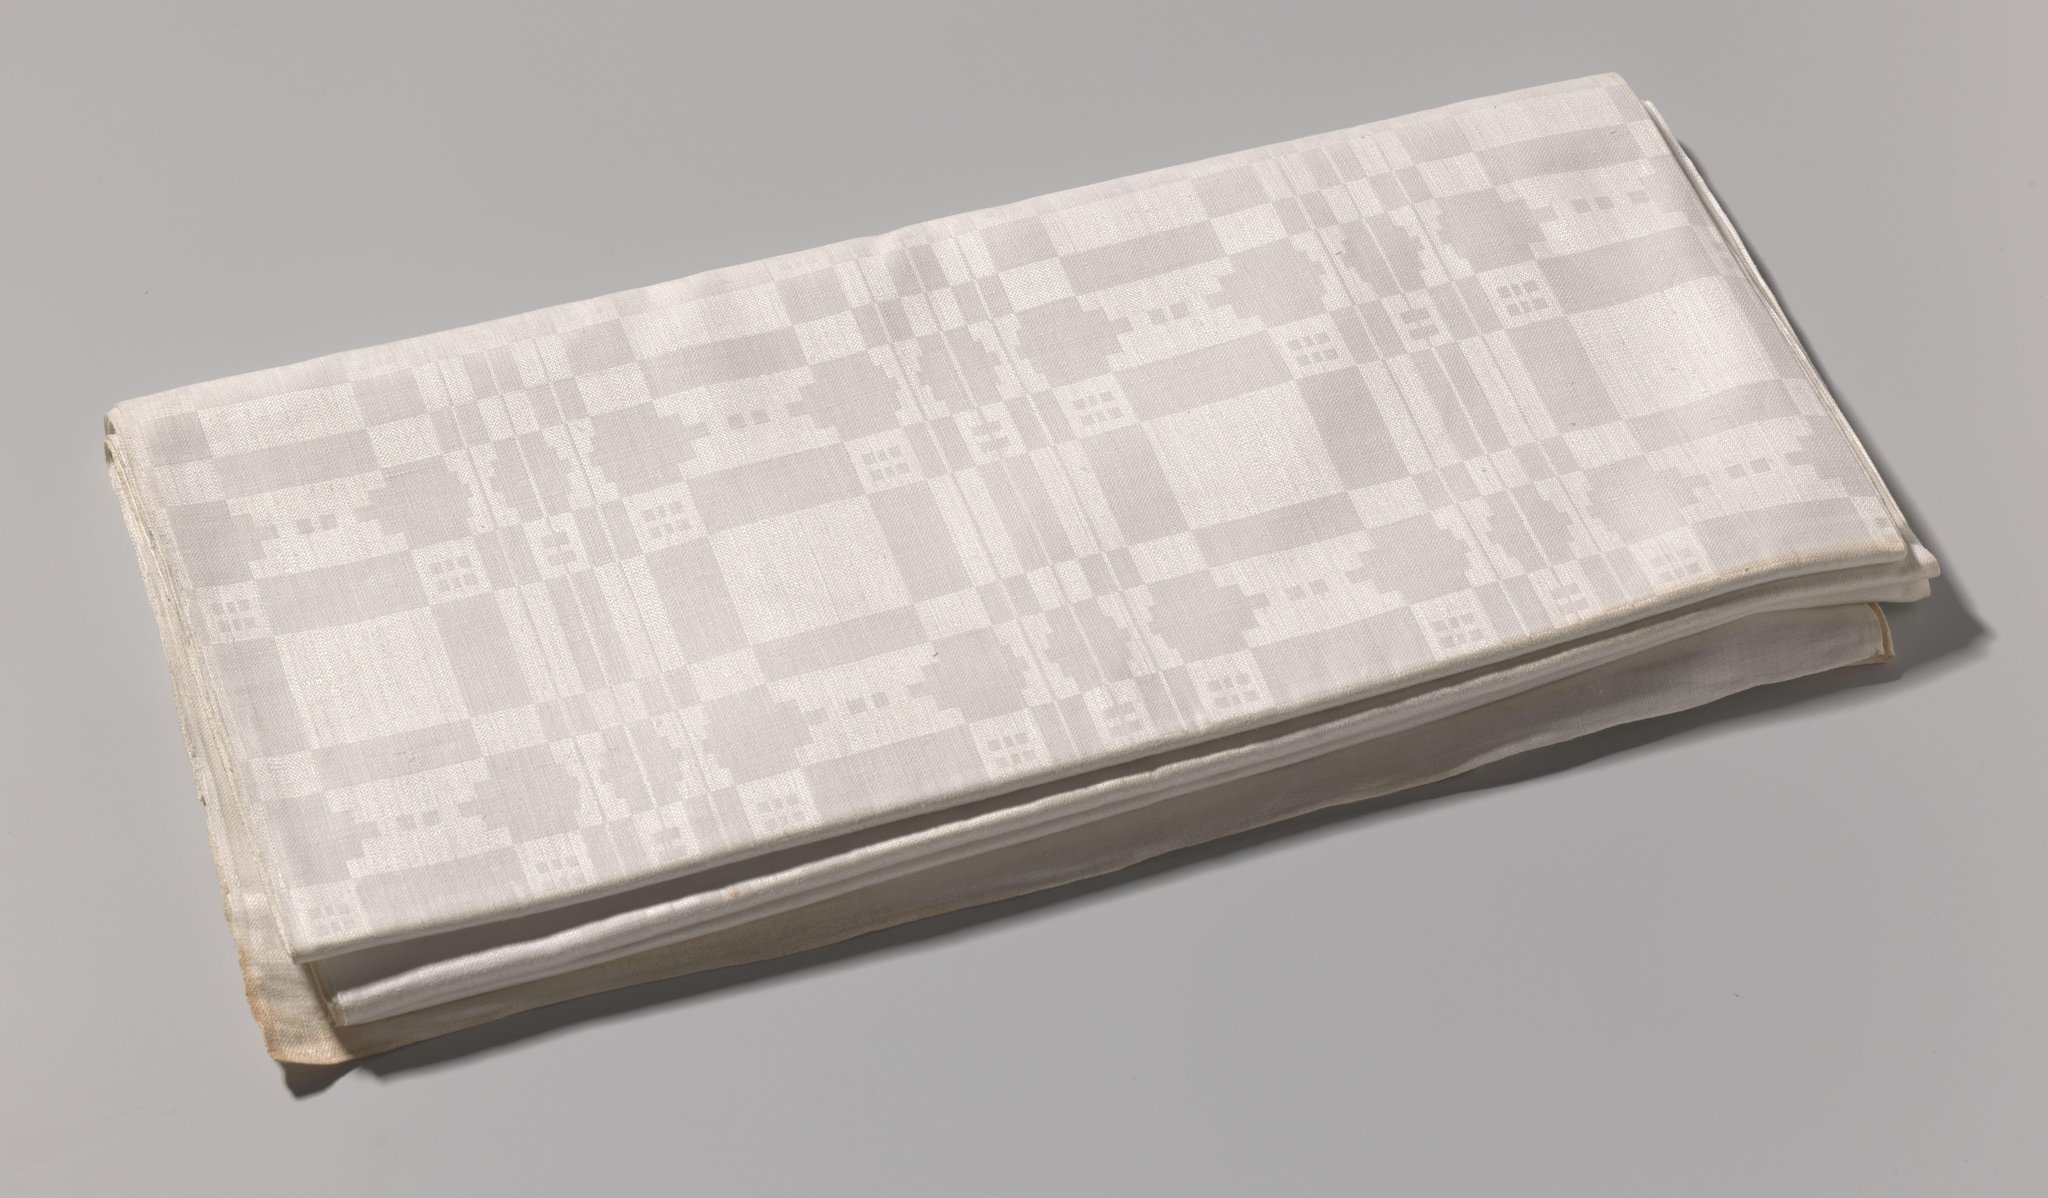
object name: tablecloth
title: Tafellaken met pellenpatroon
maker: Anonymous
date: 1742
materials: linen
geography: northern netherlands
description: Tafellaken van wit linnendamast met pellenpatroon, genaamd "Torenwerk". Merk kroon WG 3 1742.